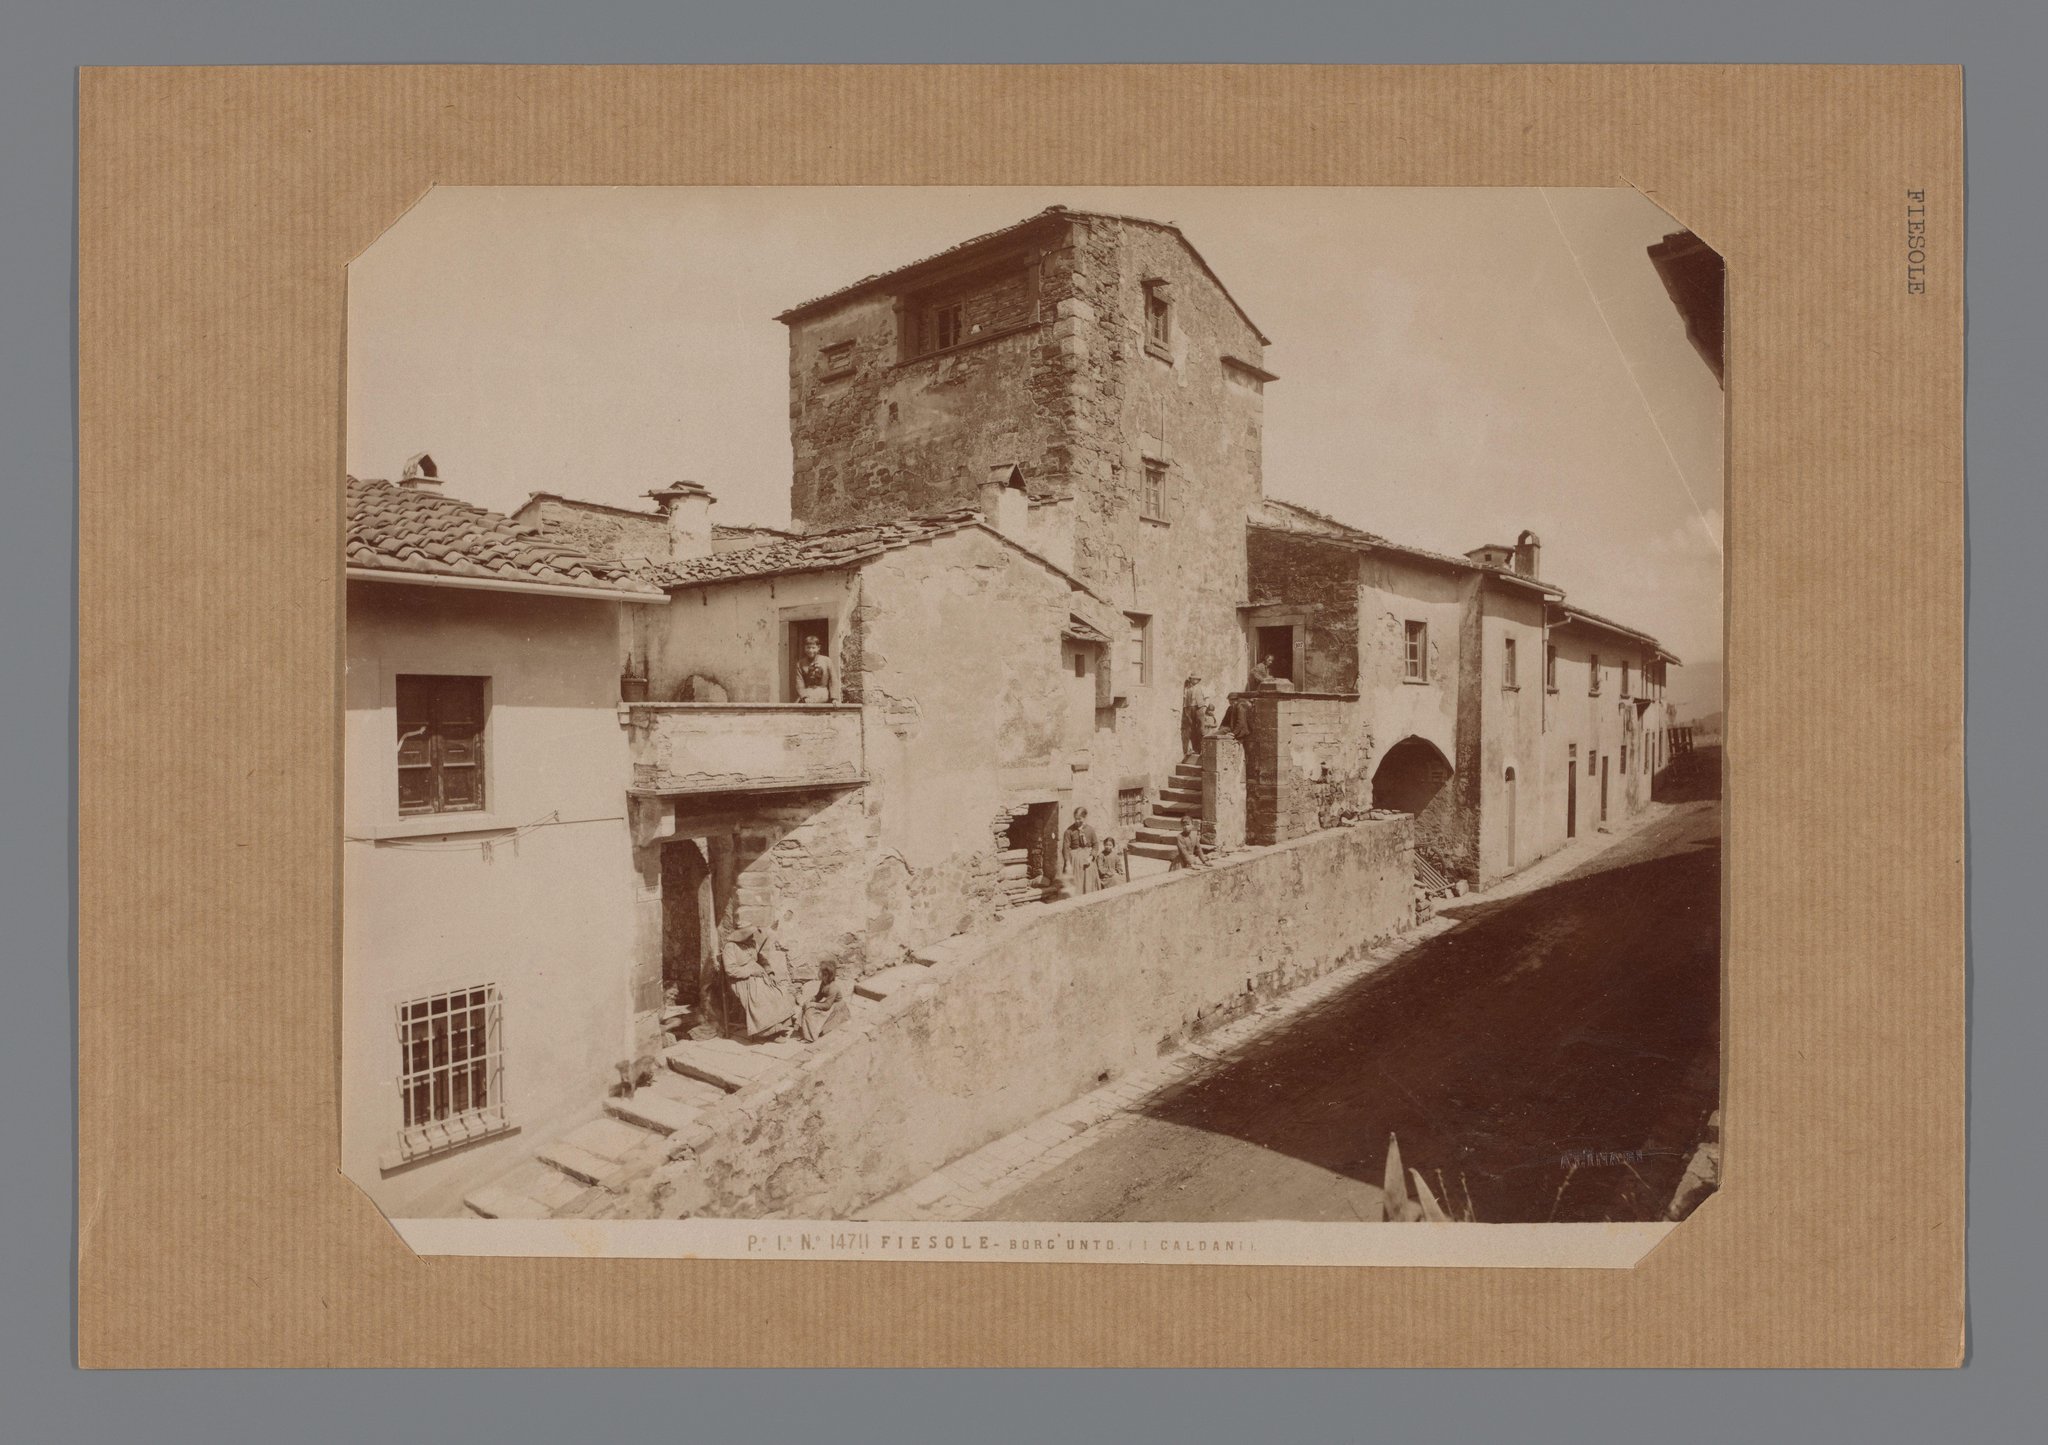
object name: photograph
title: Italië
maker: Anonymous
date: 1880-1910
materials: photographic support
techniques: albumen print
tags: italy